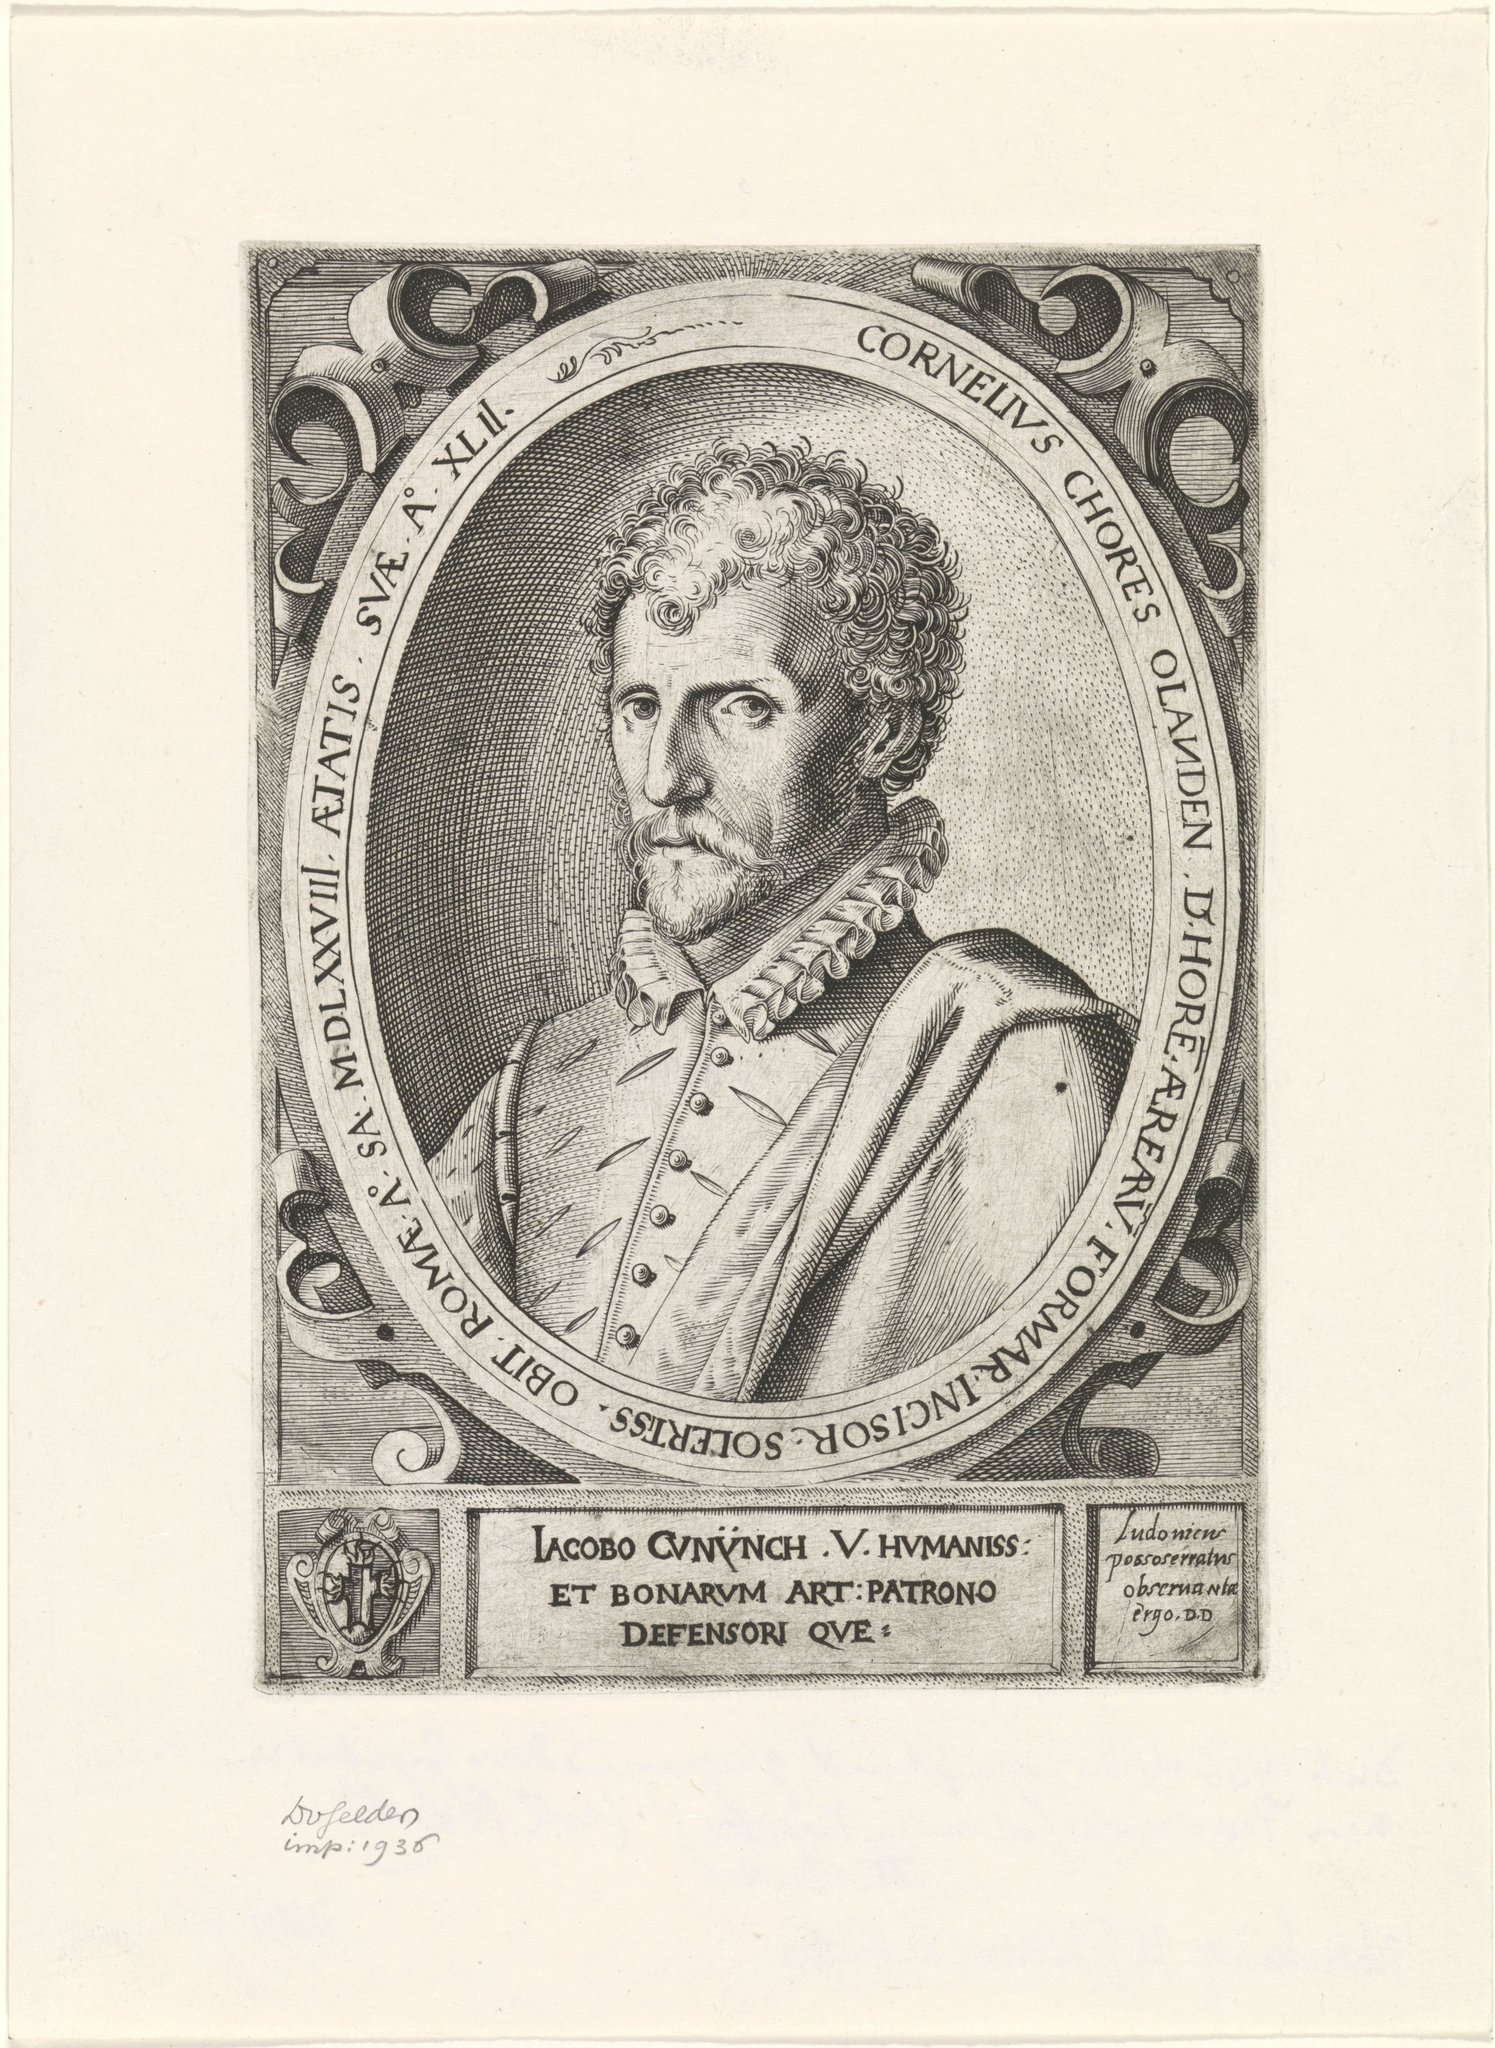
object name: print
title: Portret van de kunstenaar Cornelis Cort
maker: lodewijk toeput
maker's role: draughtsman, print maker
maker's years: 1550-1603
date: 1578-1628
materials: paper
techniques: engraving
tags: rome, cornelis cort, portrait, self-portrait of graphic artist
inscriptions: collector's mark: Lugt 2228, inscription: ‘Dofelden/ imp: 1936’